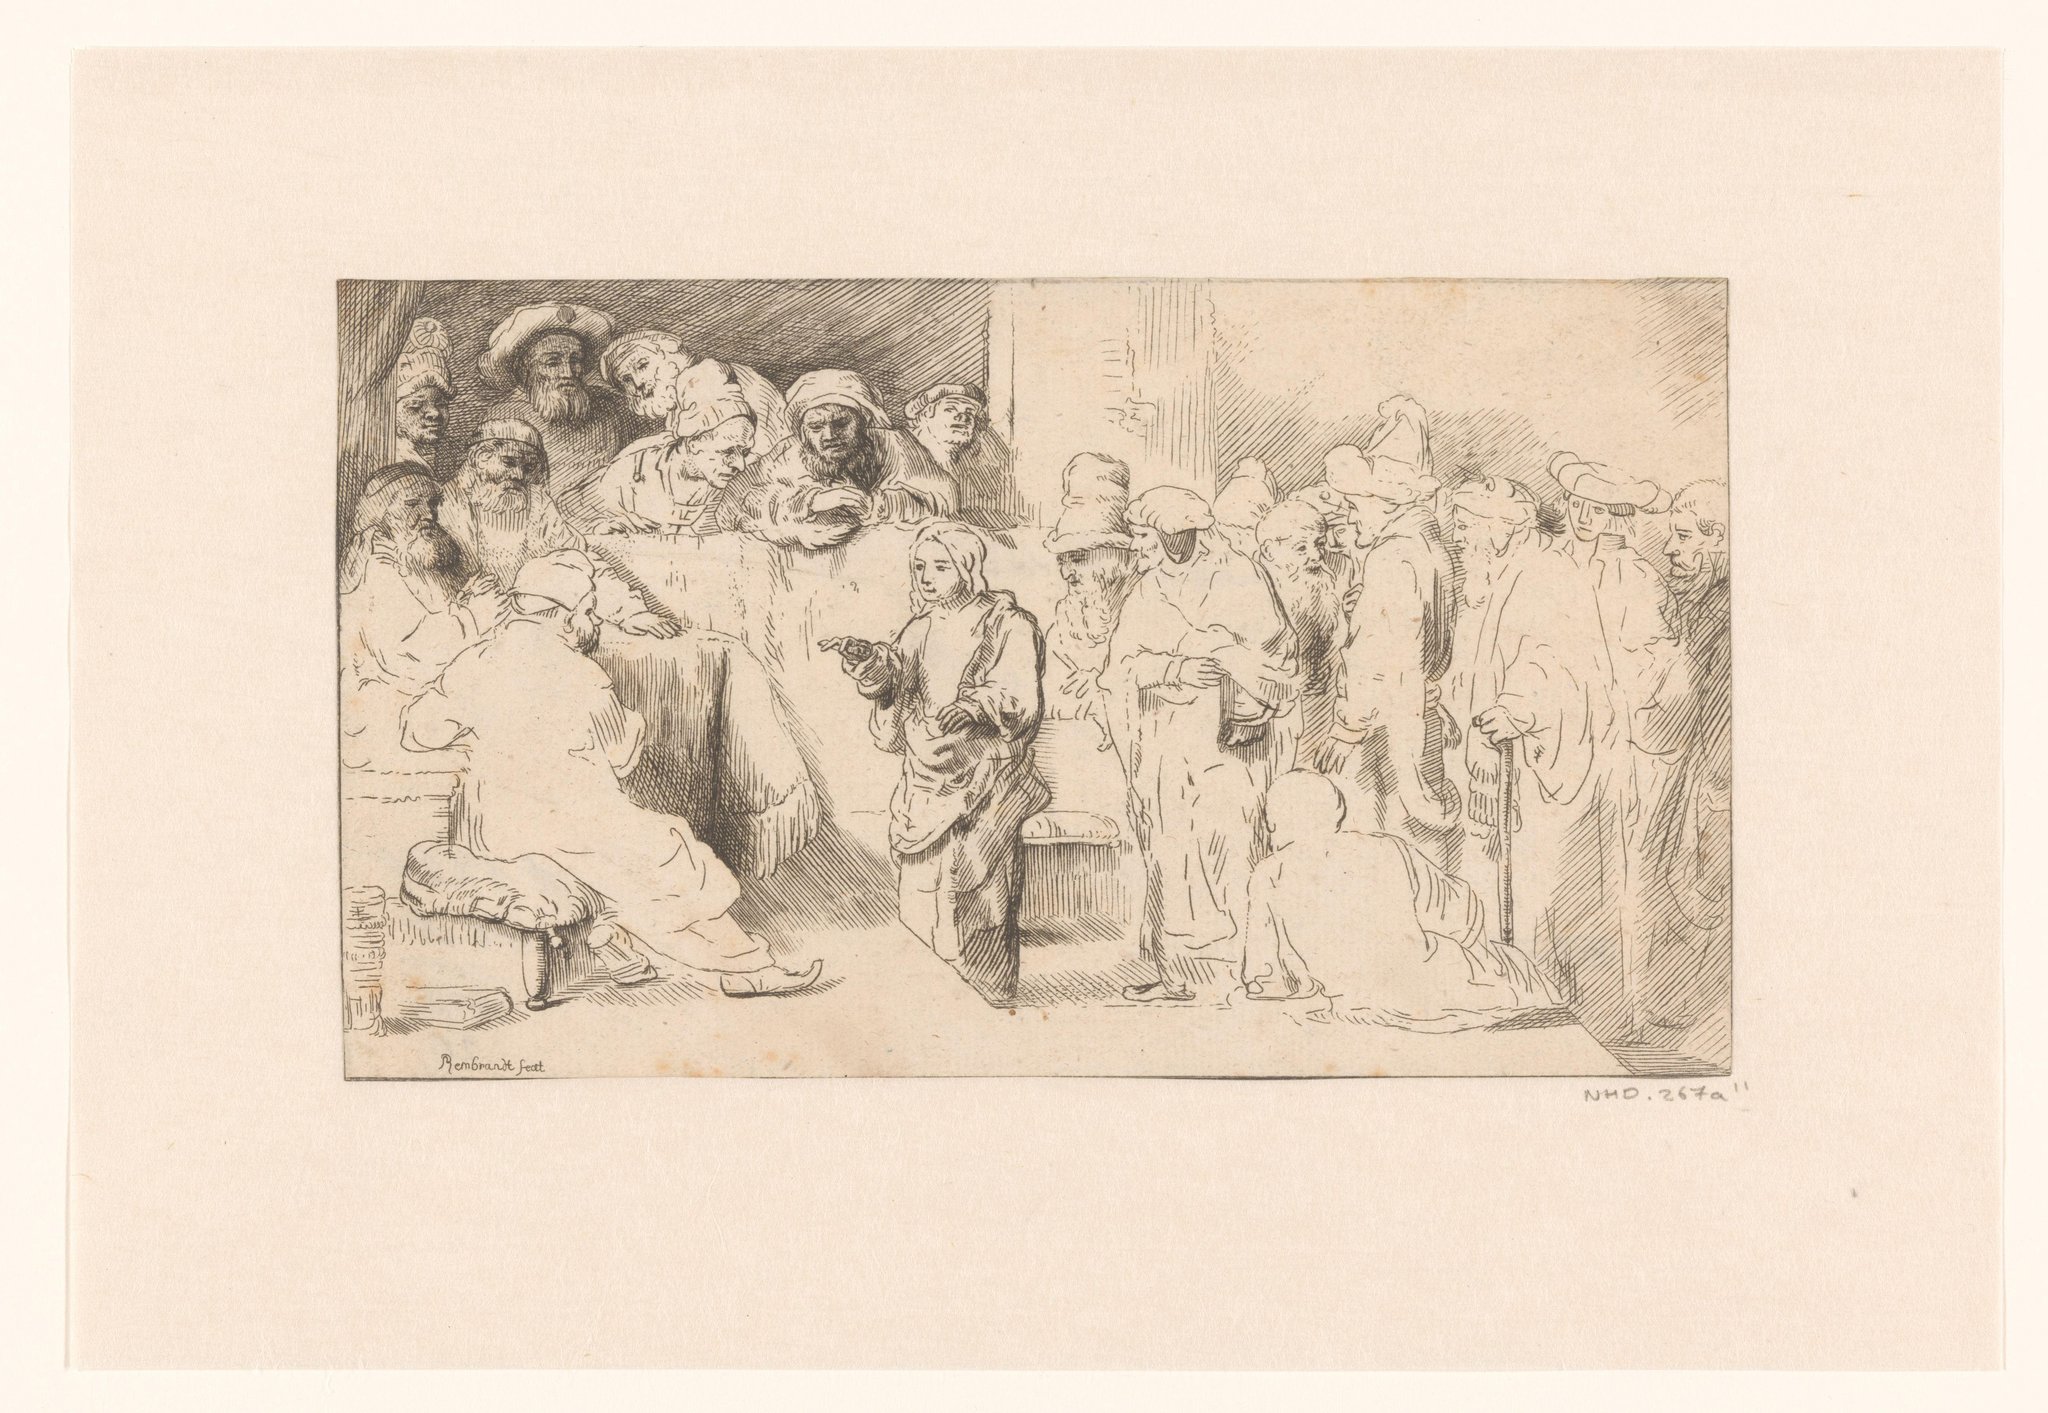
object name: print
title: Christ disputing with the doctors: a sketch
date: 1711-1800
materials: paper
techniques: etching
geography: augsburg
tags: drawing, sketch, christ explaining his doctrine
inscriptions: collector's mark: Lugt 2228, collector's mark: Lugt 2760, collector's mark: Lugt 4071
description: Spiegelbeeldige kopie naar de gelijknamige prent van Rembrandt.